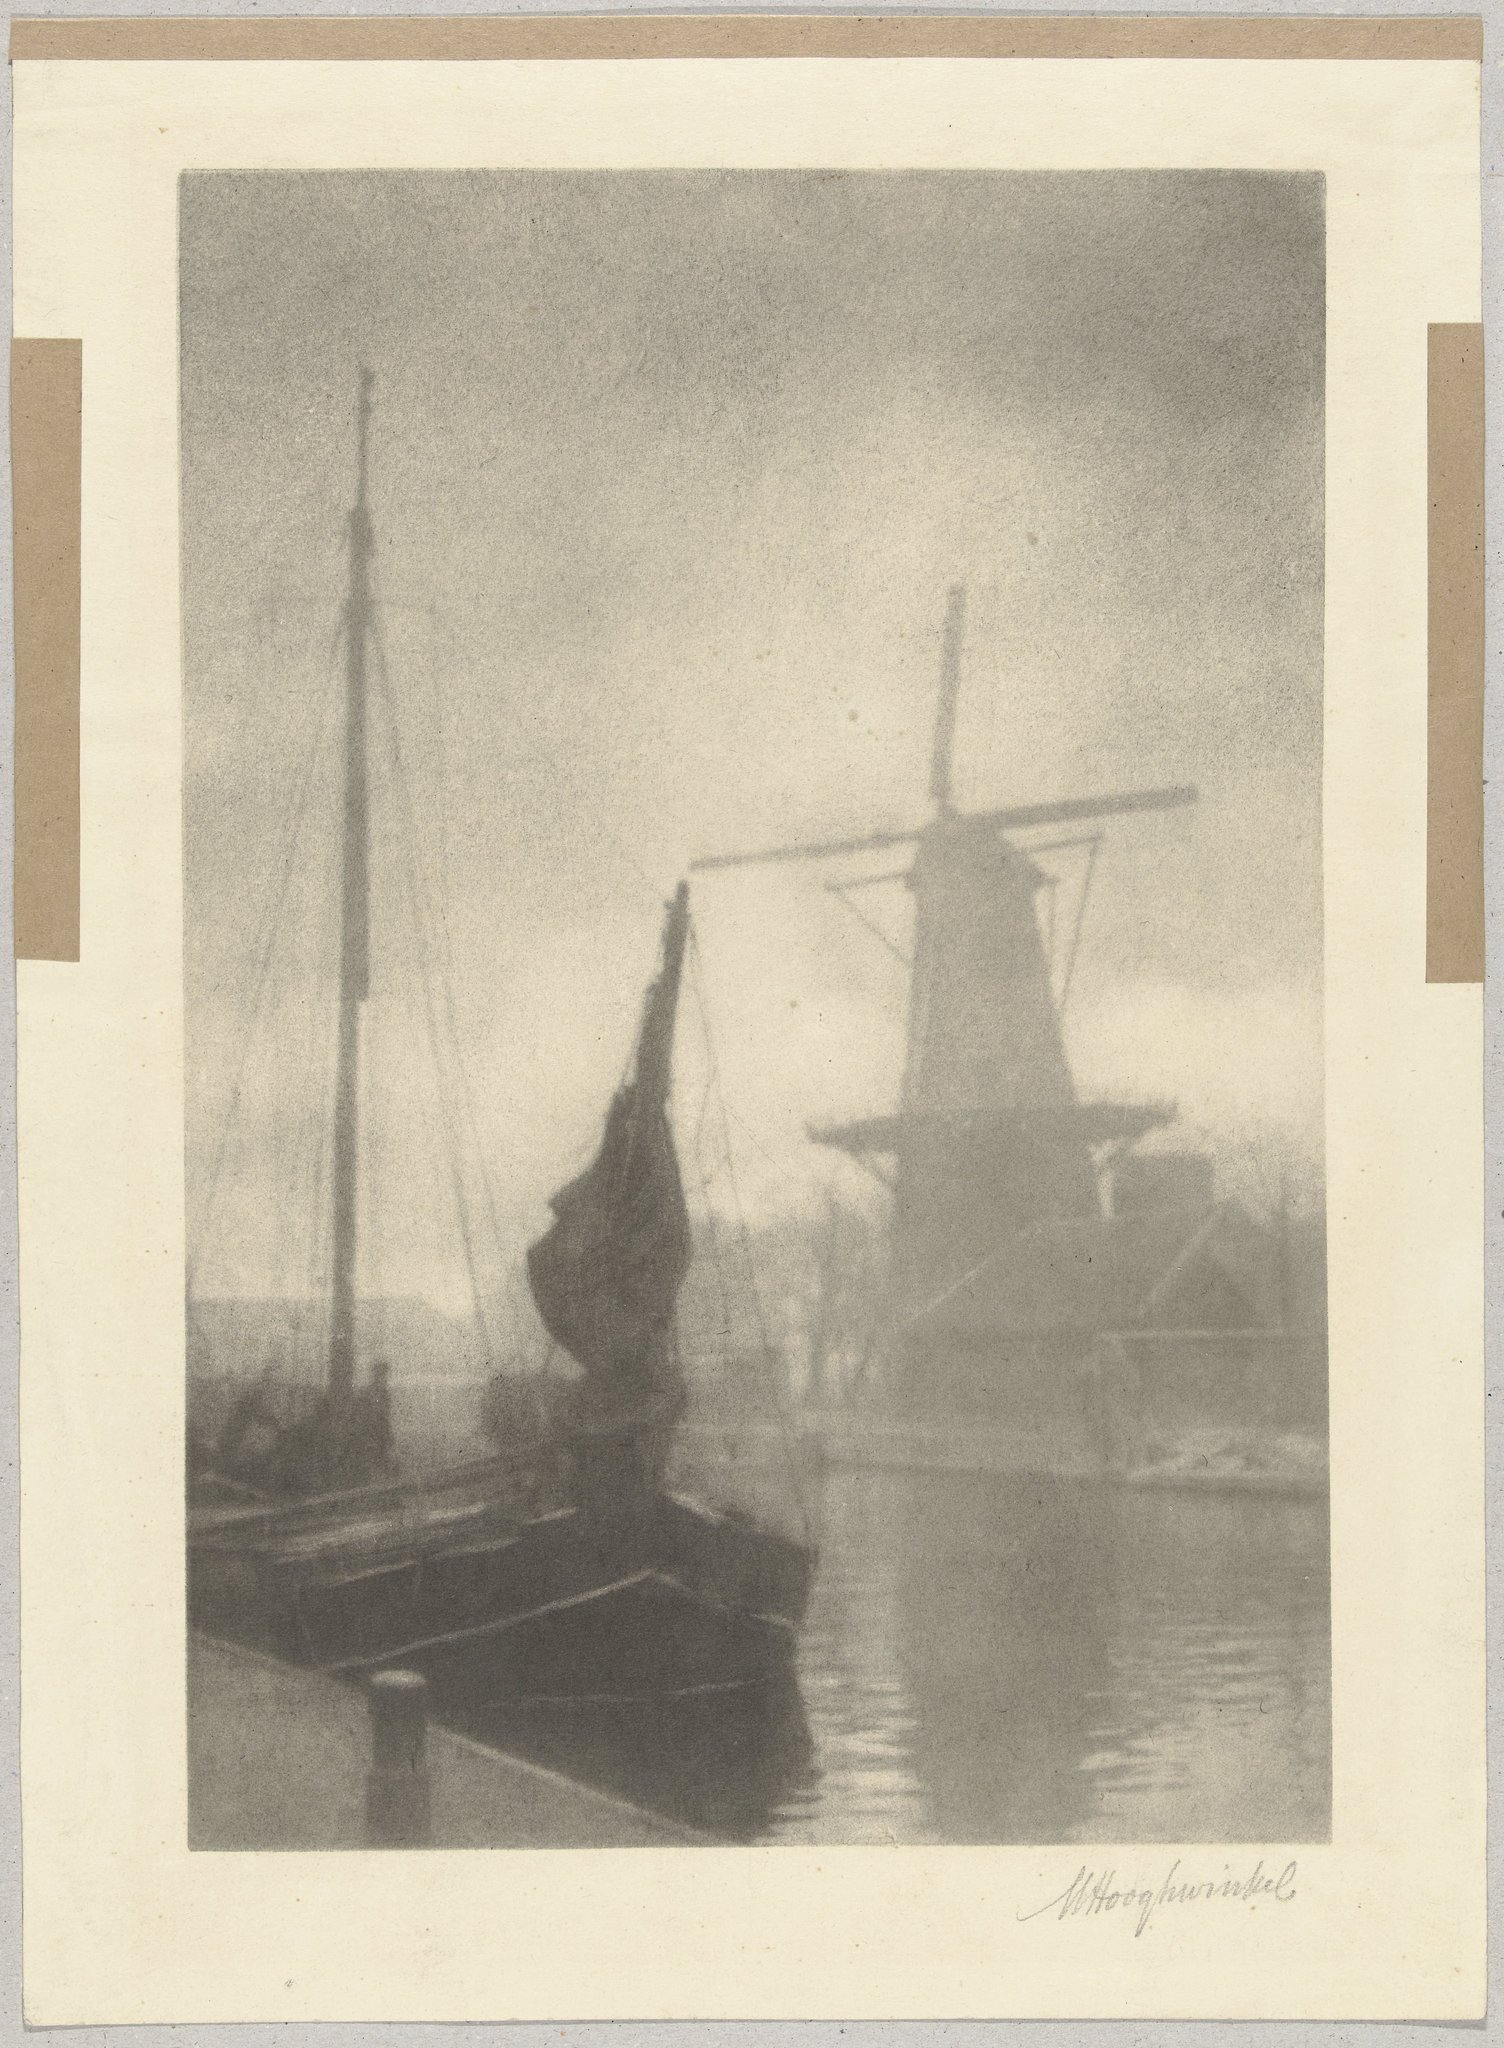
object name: photograph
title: Gezicht op een molen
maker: mattheus hooghwinkel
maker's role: fotograaf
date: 1920-1930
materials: paper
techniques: oil transfer print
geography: arnhem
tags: windmill in landscape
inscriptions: signature: ‘'M. Hooghwinkel'’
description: De foto is uitgeleend aan de uitgever Maatschappij Focus voor een tentoonstelling in Japan en daarna geretourneerd aan de heer Hooghwinkel, zie verso foto.